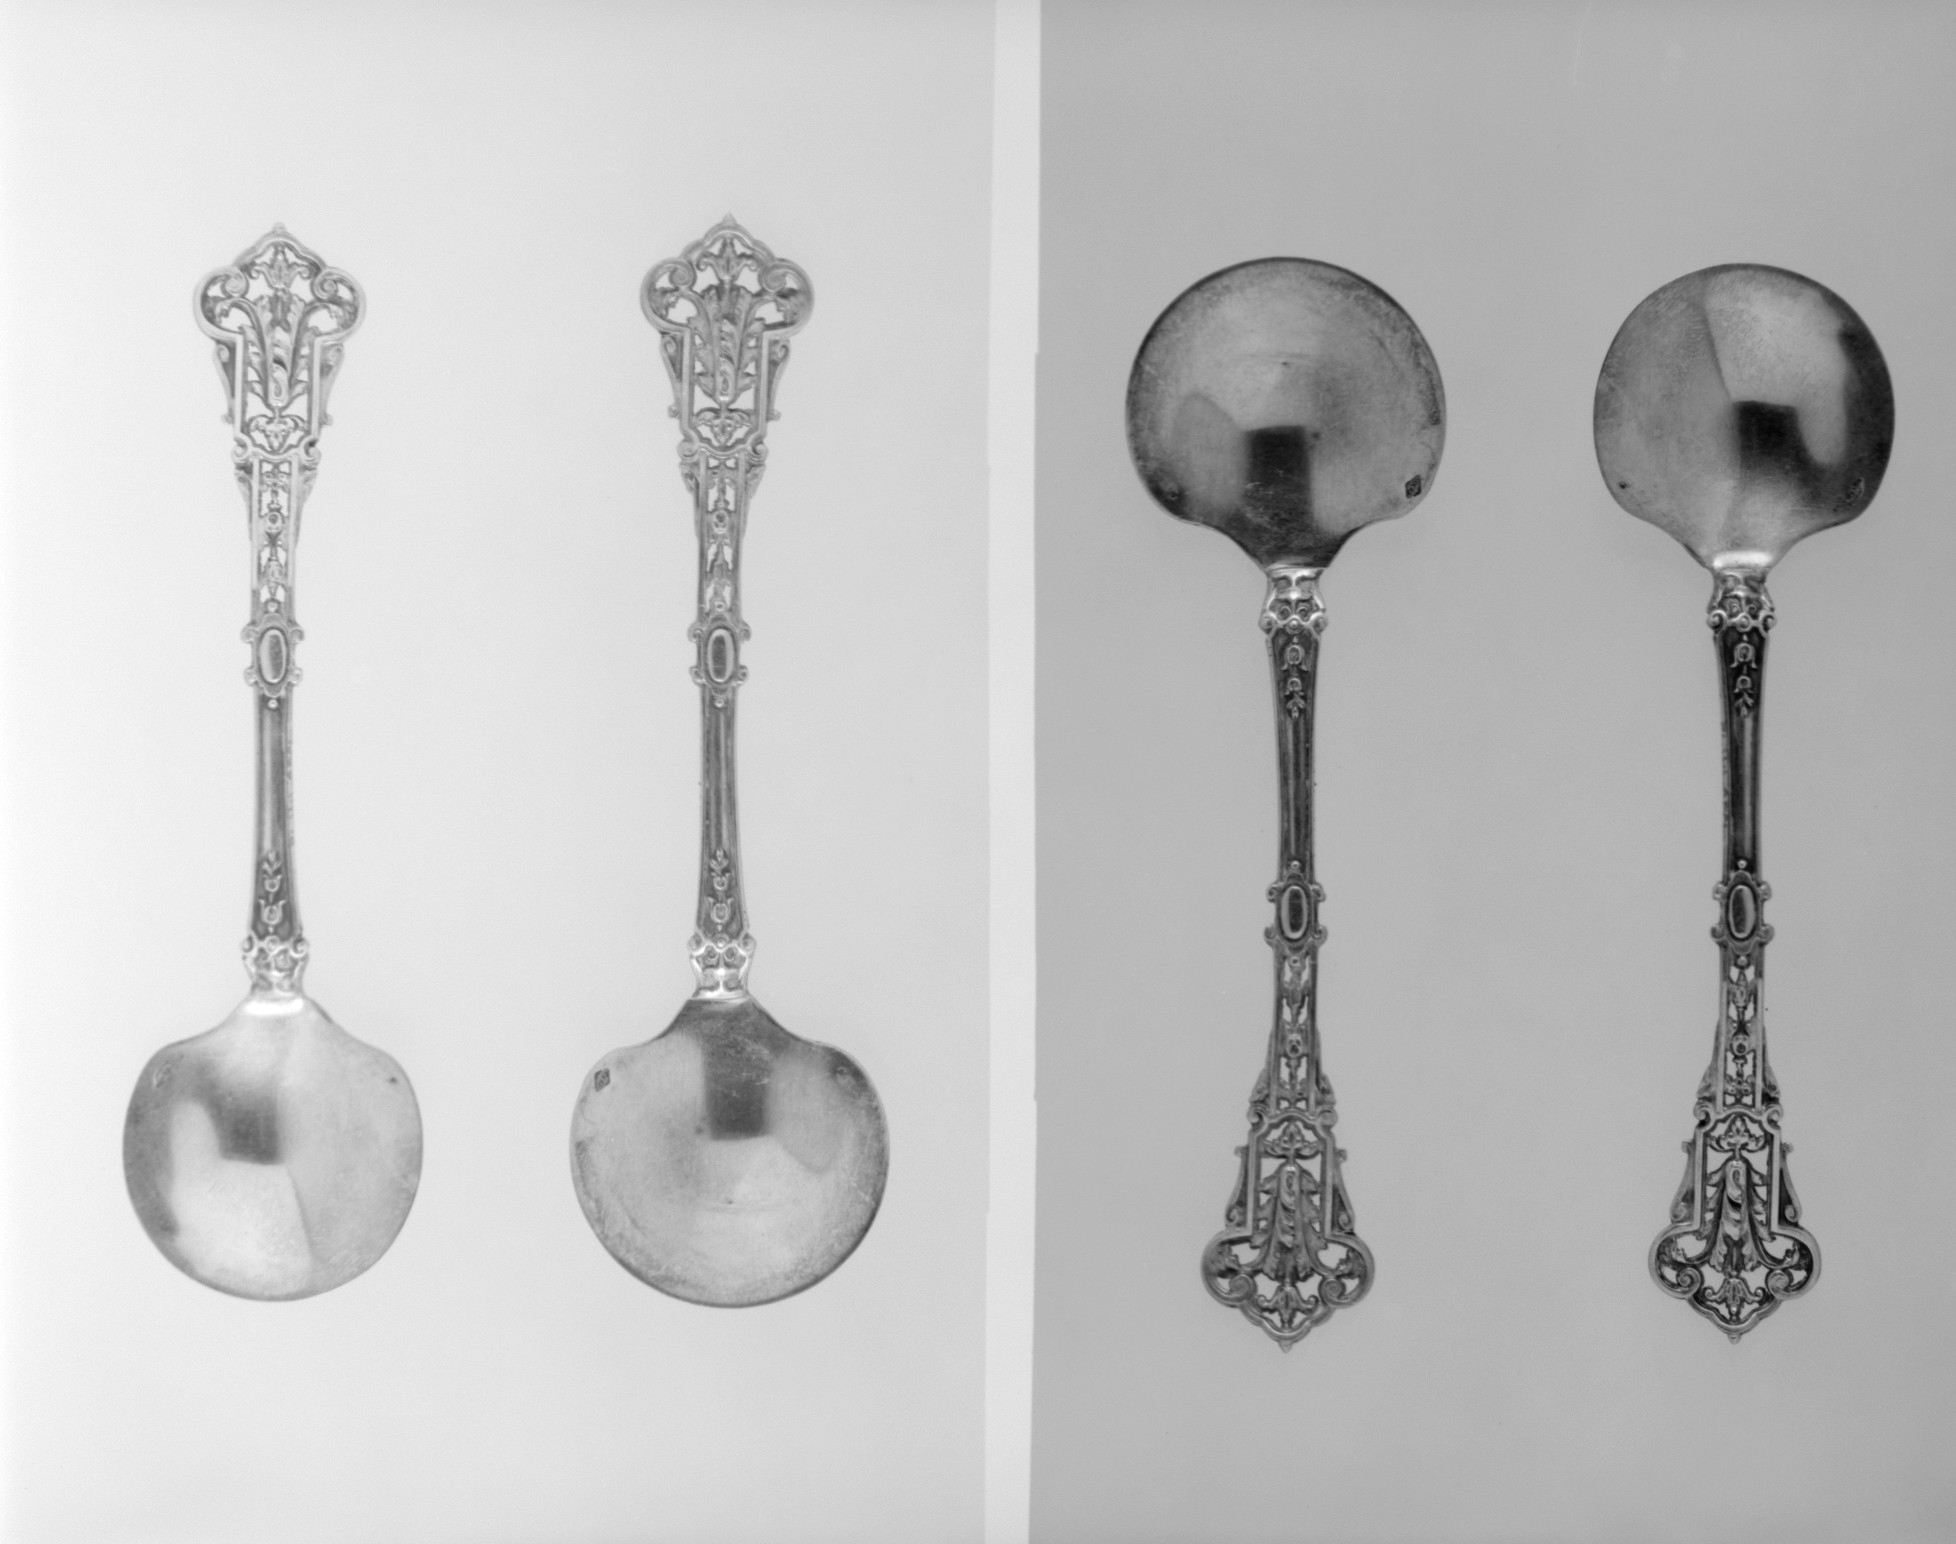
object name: ice cream spoon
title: Ice cream spoon (one of a pair)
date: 1801-1900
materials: silver